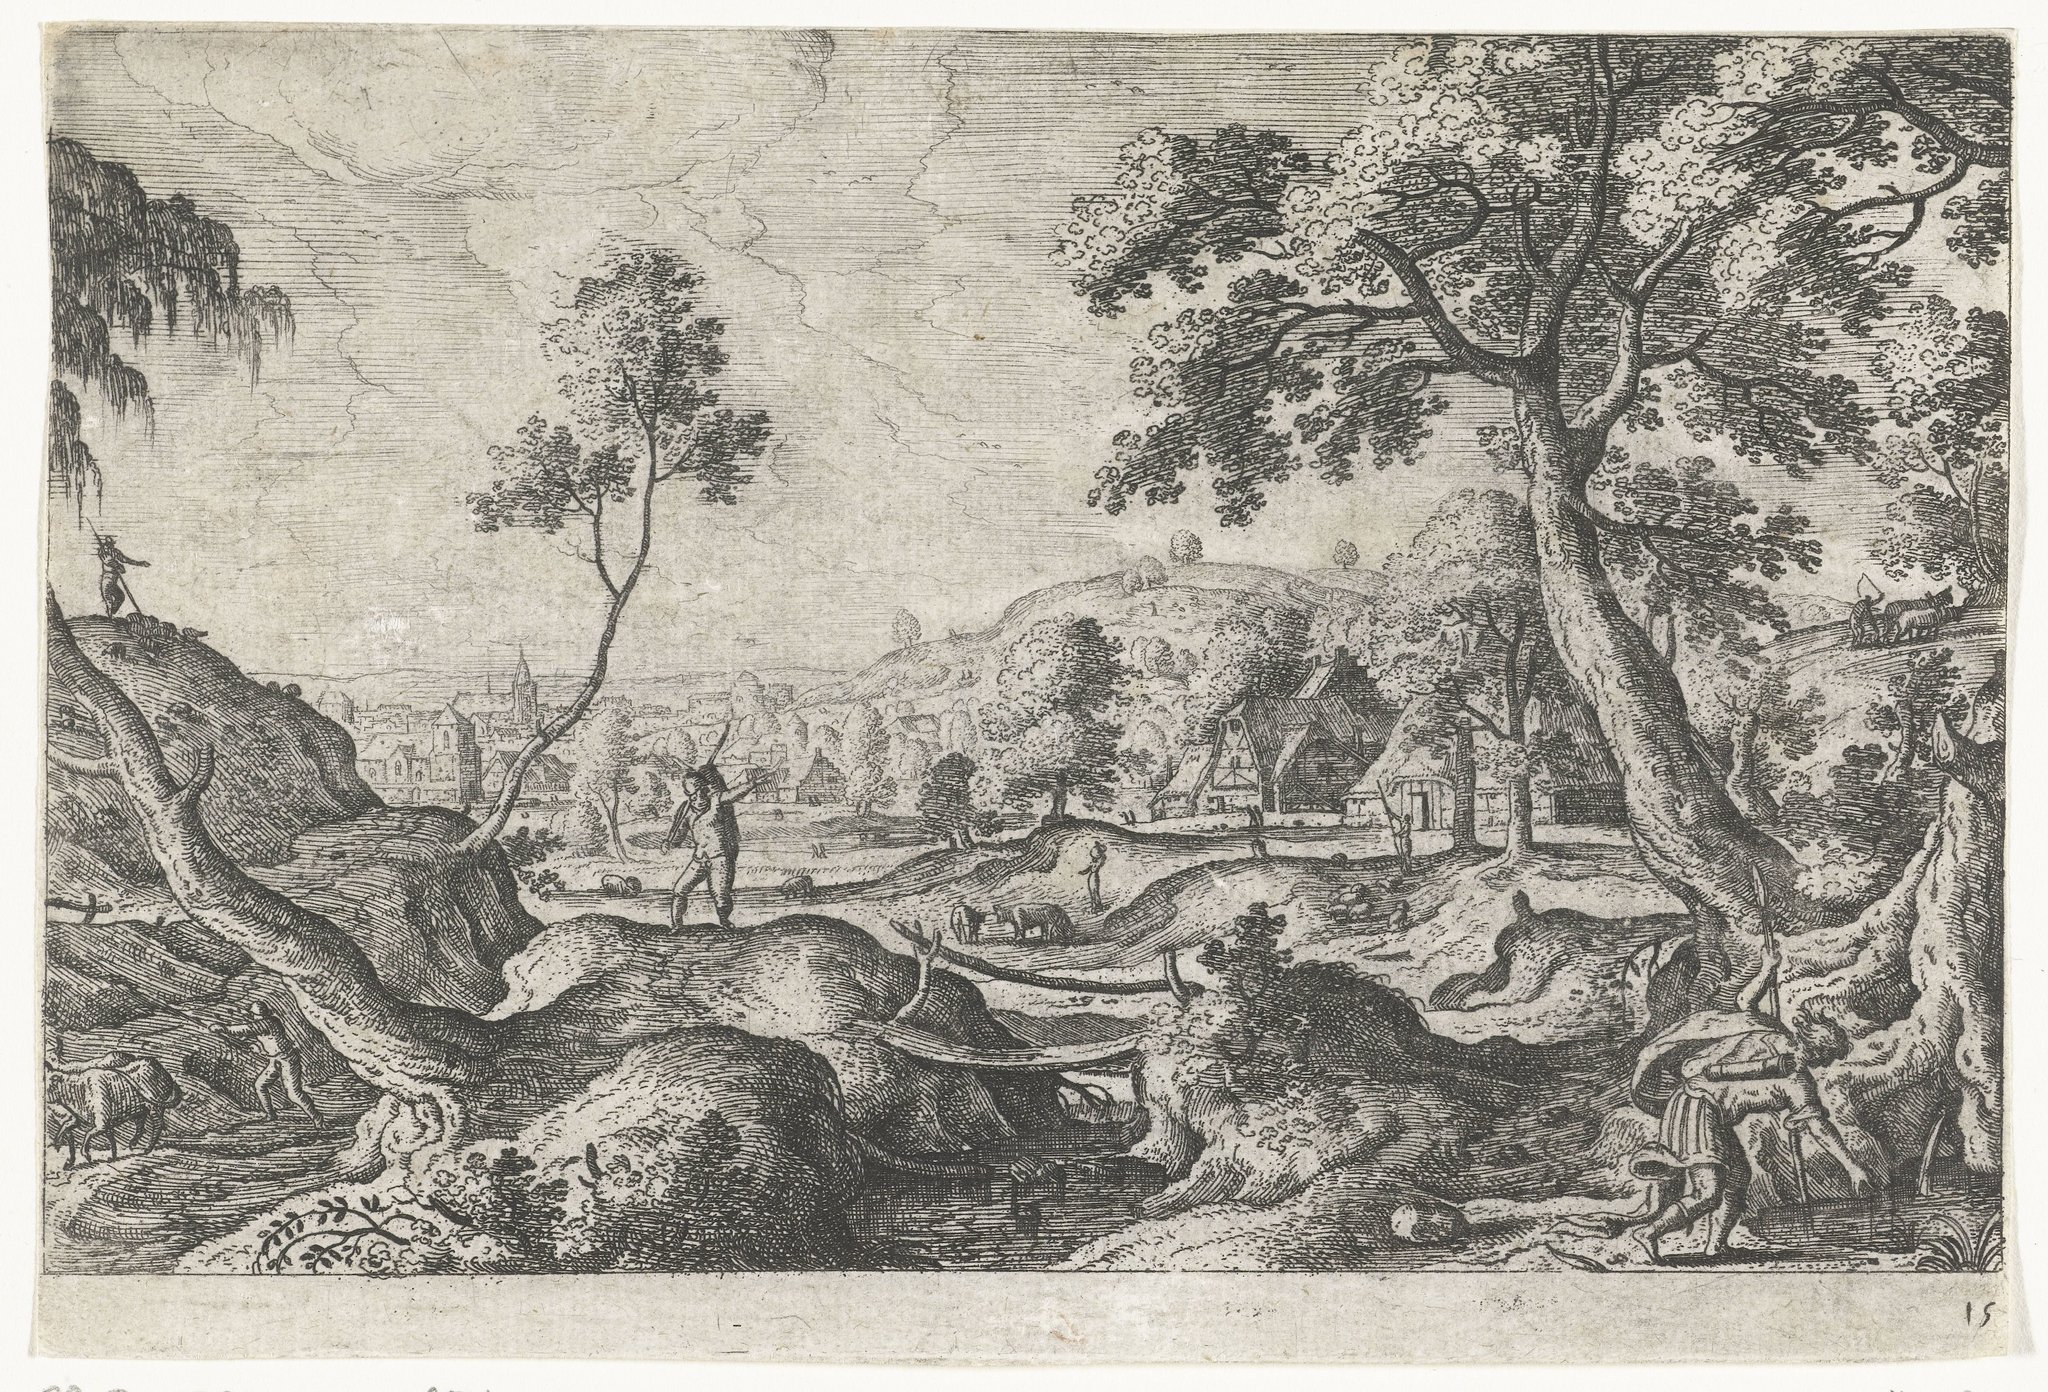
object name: print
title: Apollo drinkt water uit een bron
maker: Anonymous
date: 1550-1650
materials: paper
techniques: etching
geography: southern netherlands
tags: (story of) apollo (phoebus)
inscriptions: collector's mark: Lugt 2228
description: Serie van 30 genummerde prenten. Volgorde blijft onduidelijk, omdat de nummering van verschillende staten (met of zonder onderschrift) afwijkt.